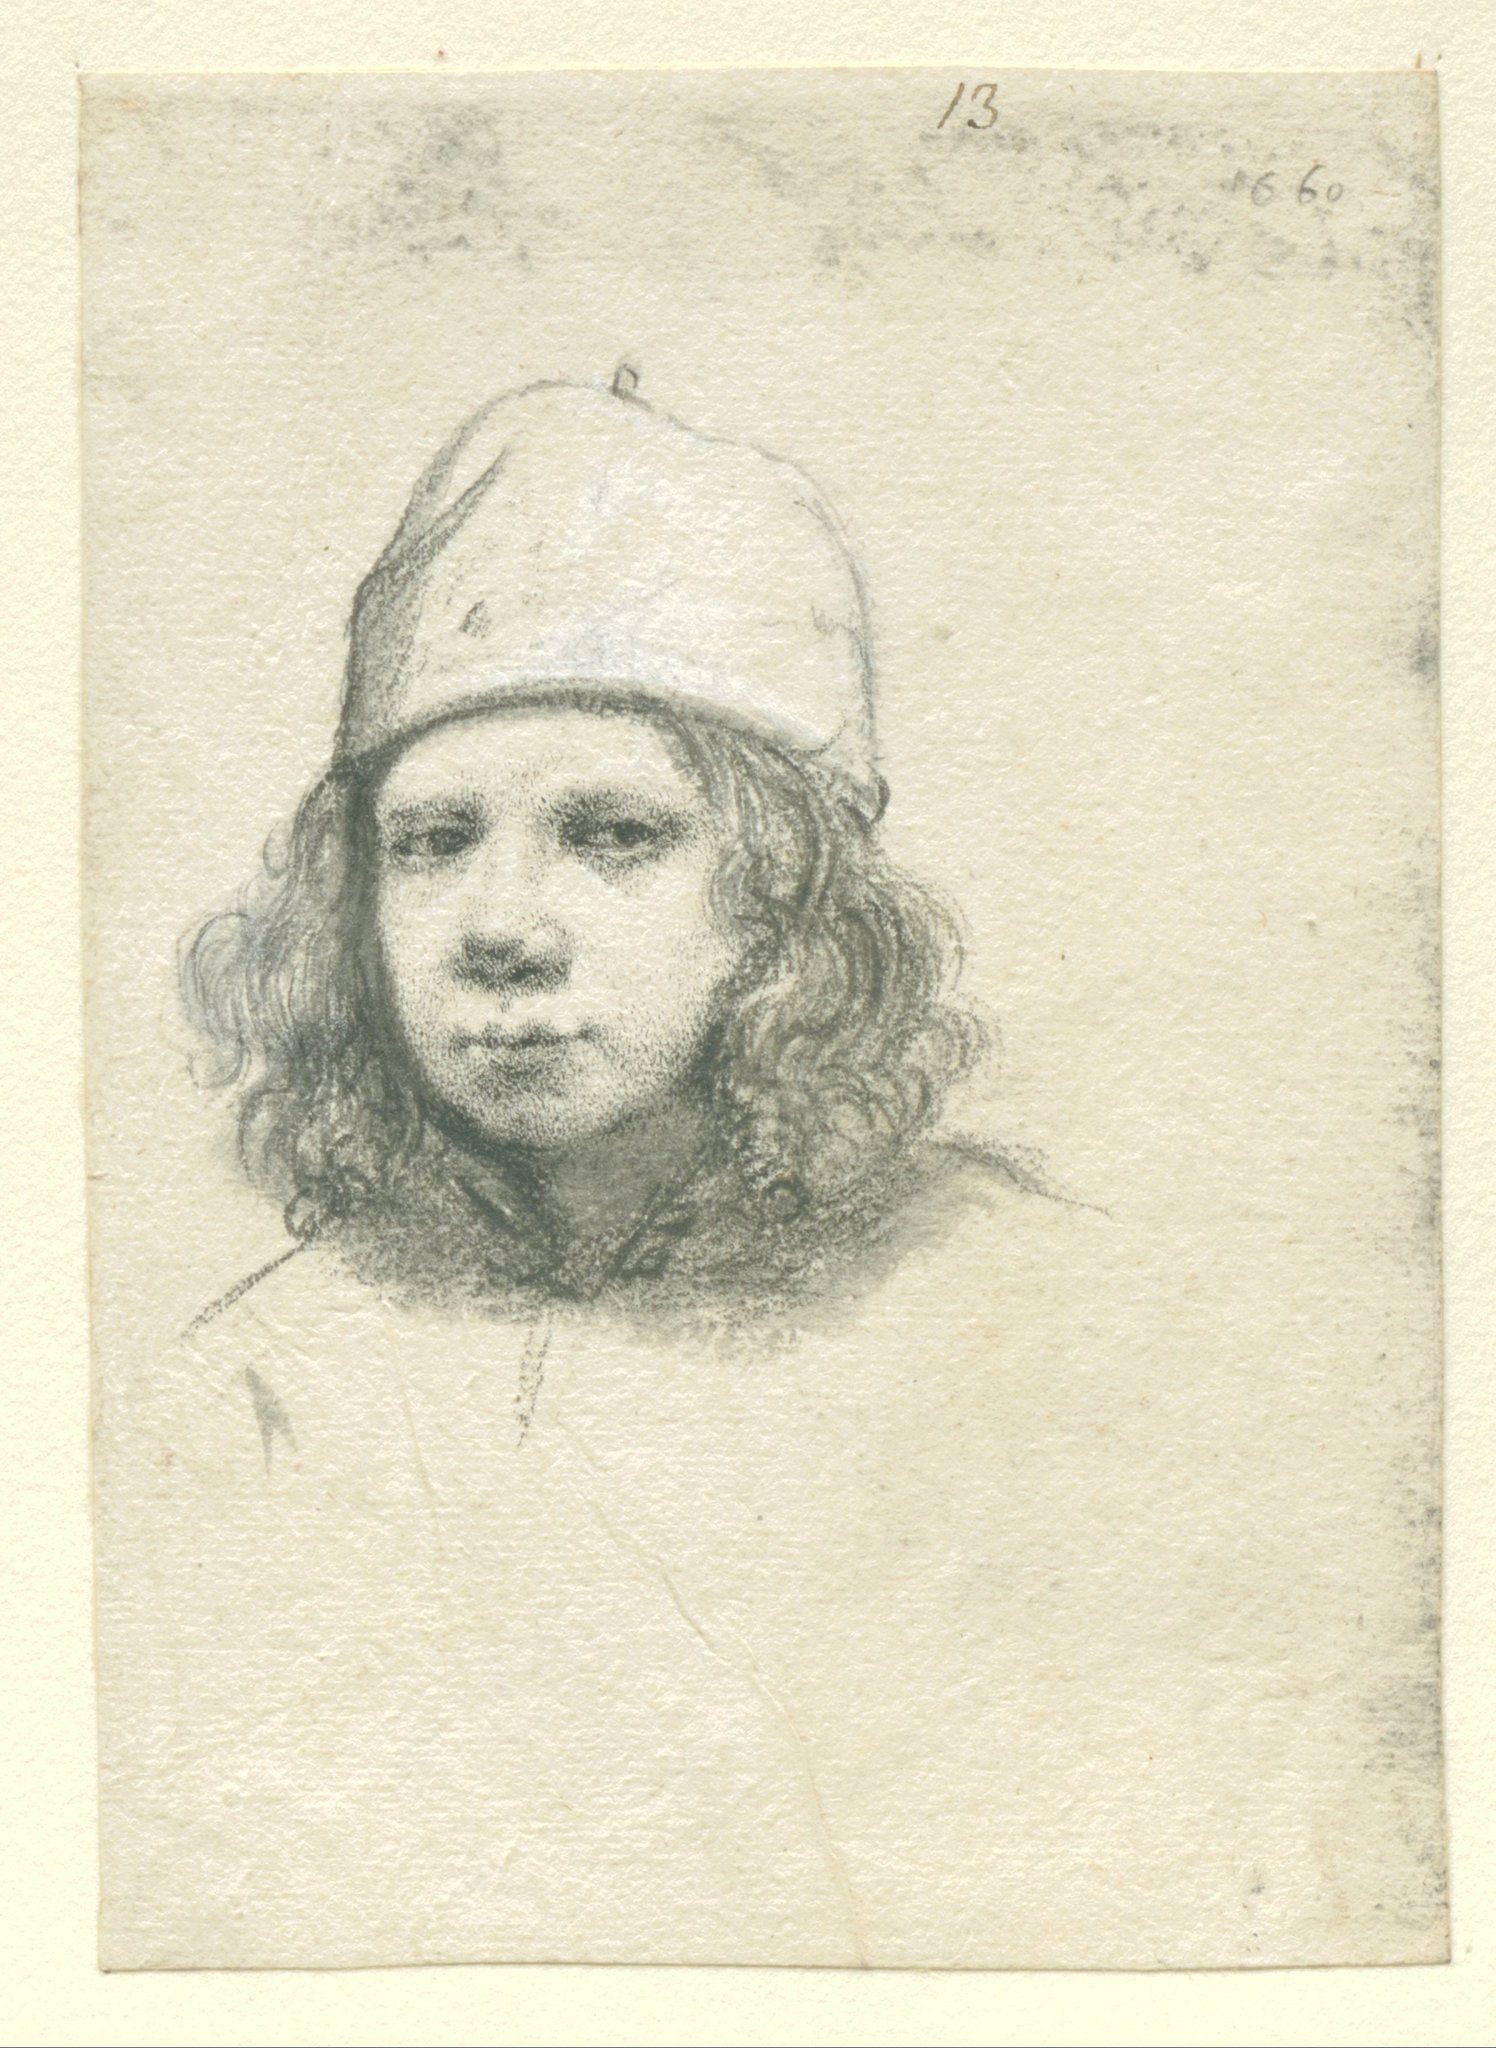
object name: drawing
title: Zelfportret van Moses ter Borch met muts, van voren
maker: moses ter borch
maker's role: draughtsman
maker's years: 1645-1667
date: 1660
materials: chalk, paint, gouache, ink, paper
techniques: brush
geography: zwolle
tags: head-gear: cap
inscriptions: date: ‘1660’, annotation: ‘13 ; verso: 10’